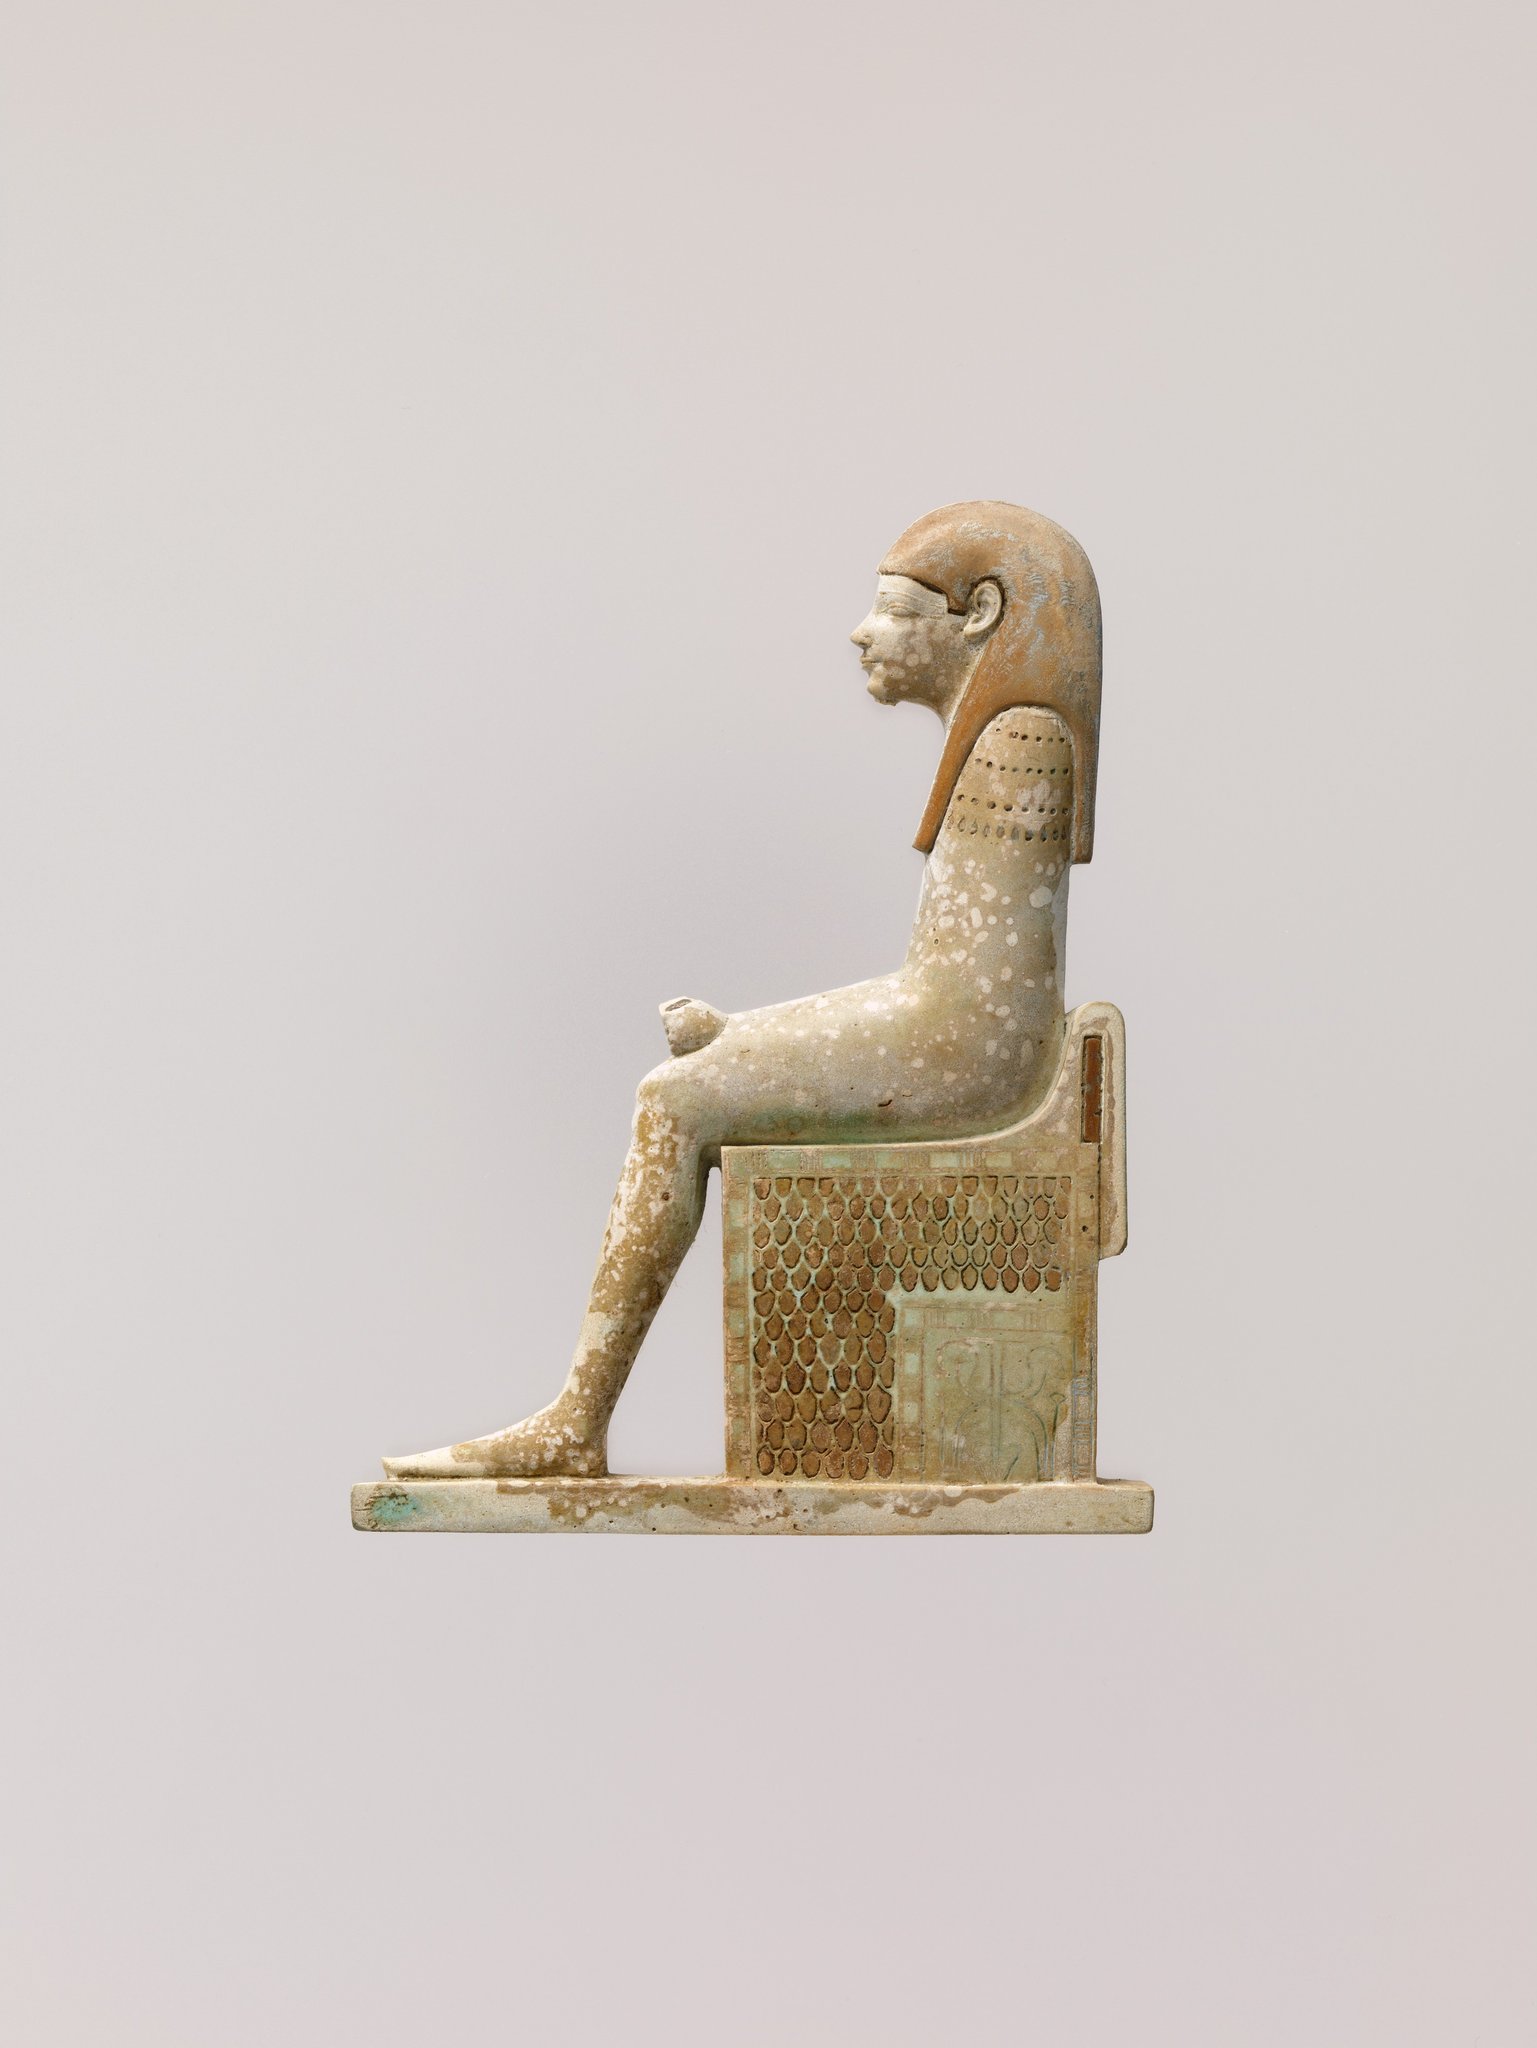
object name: inlay, god on throne, facing left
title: Inlay depicting enthroned god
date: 400-301 BCE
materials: faience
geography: middle egypt